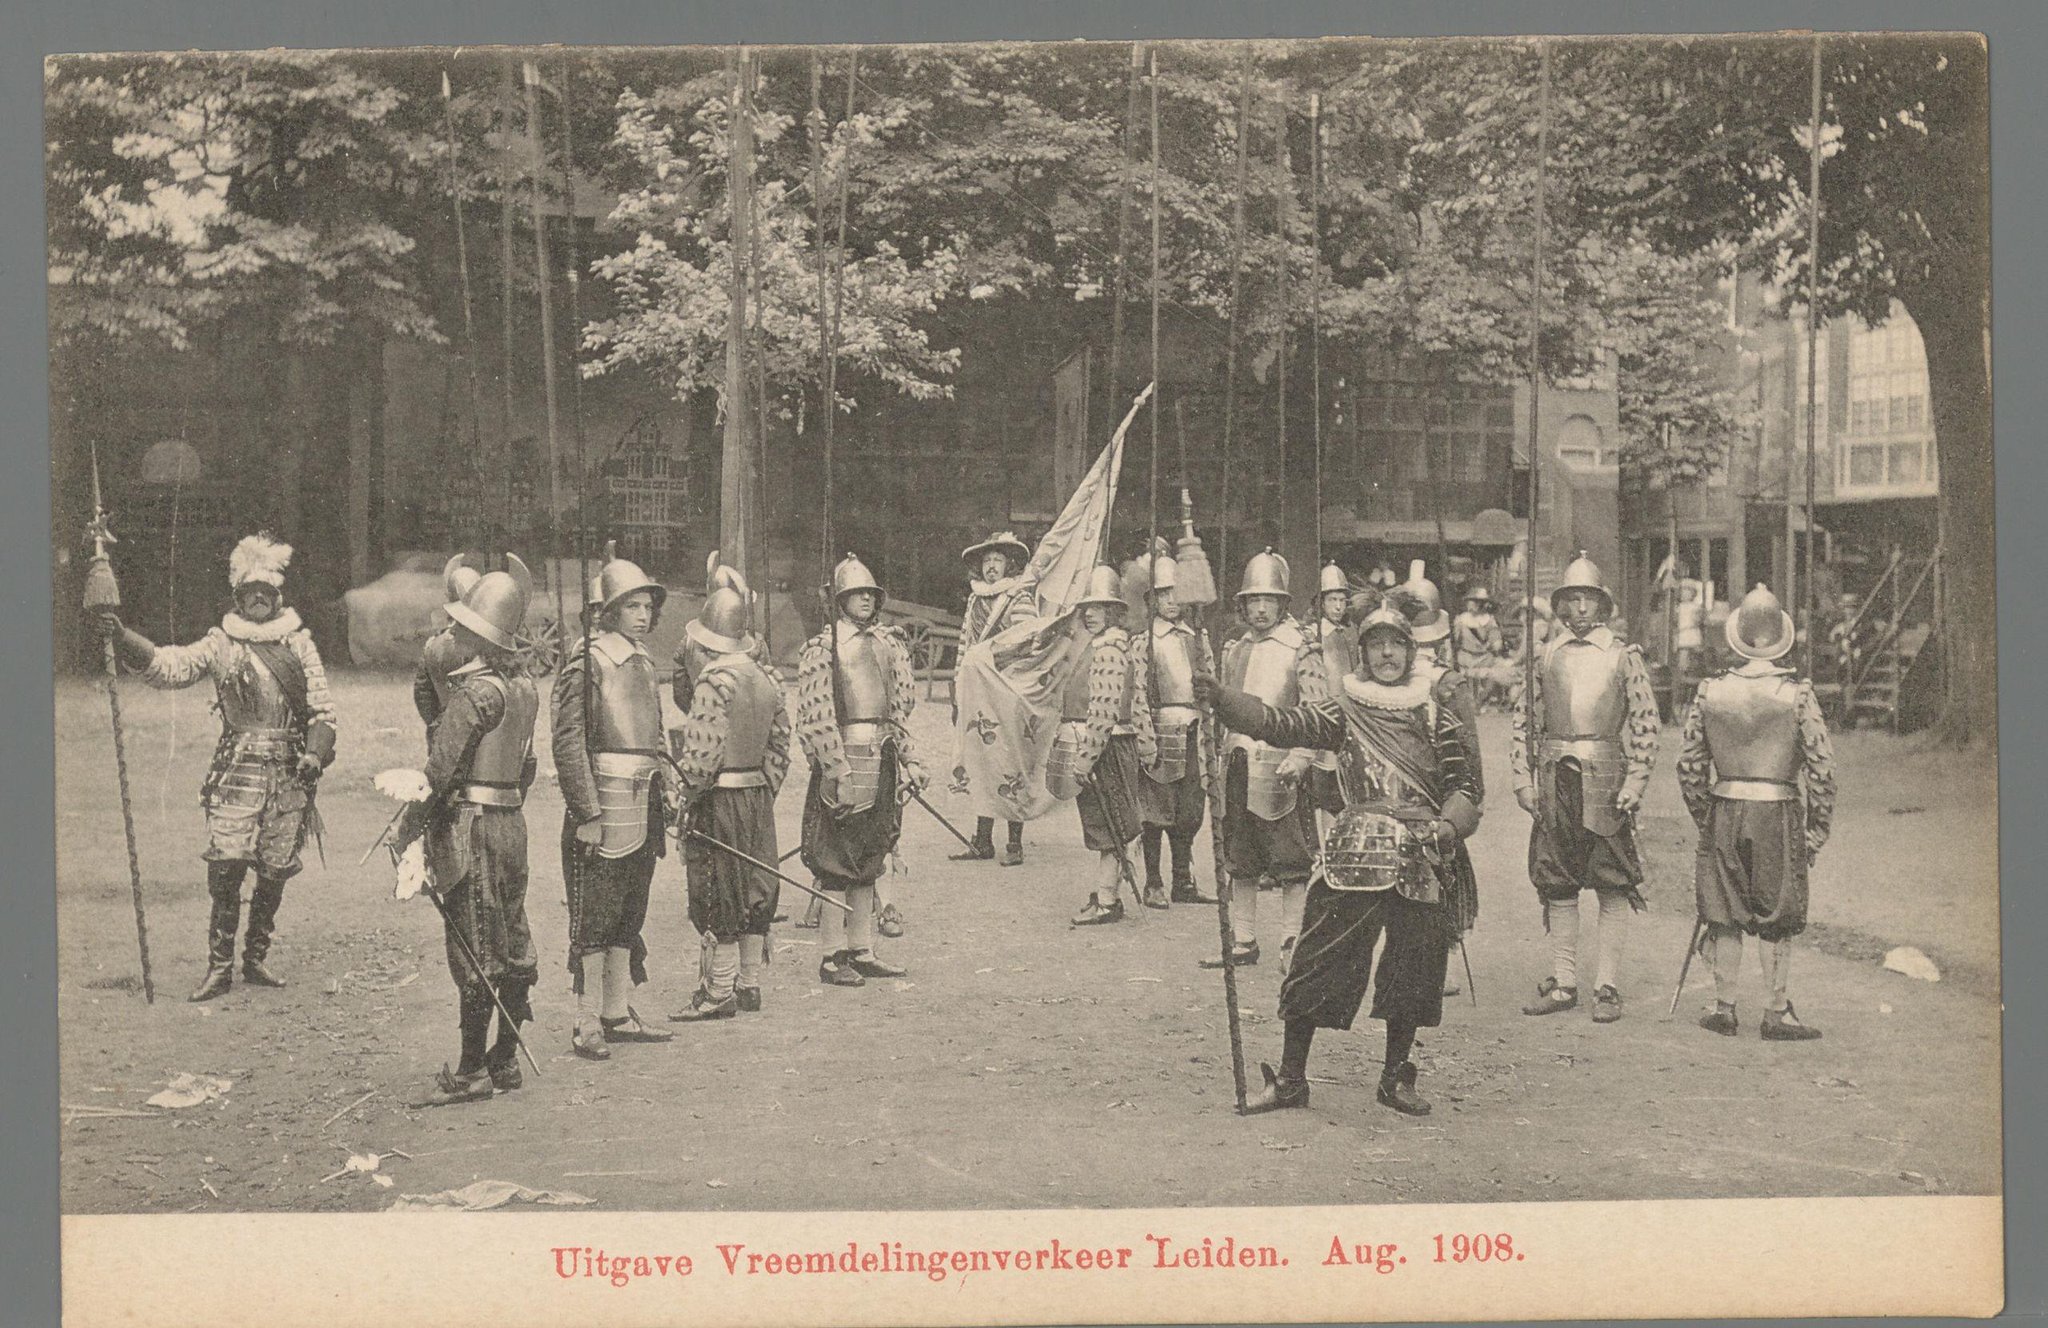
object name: ansichtkaart, prentbriefkaart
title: Mannen in kostuum tijdens de Oud-Hollandse feesten te Leiden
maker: Anonymous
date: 1908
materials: cardboard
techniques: photograph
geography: leiden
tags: dress-up party, standard-bearer, flag-bearer, armour, casting weapons: spear, festivities, leiden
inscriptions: date